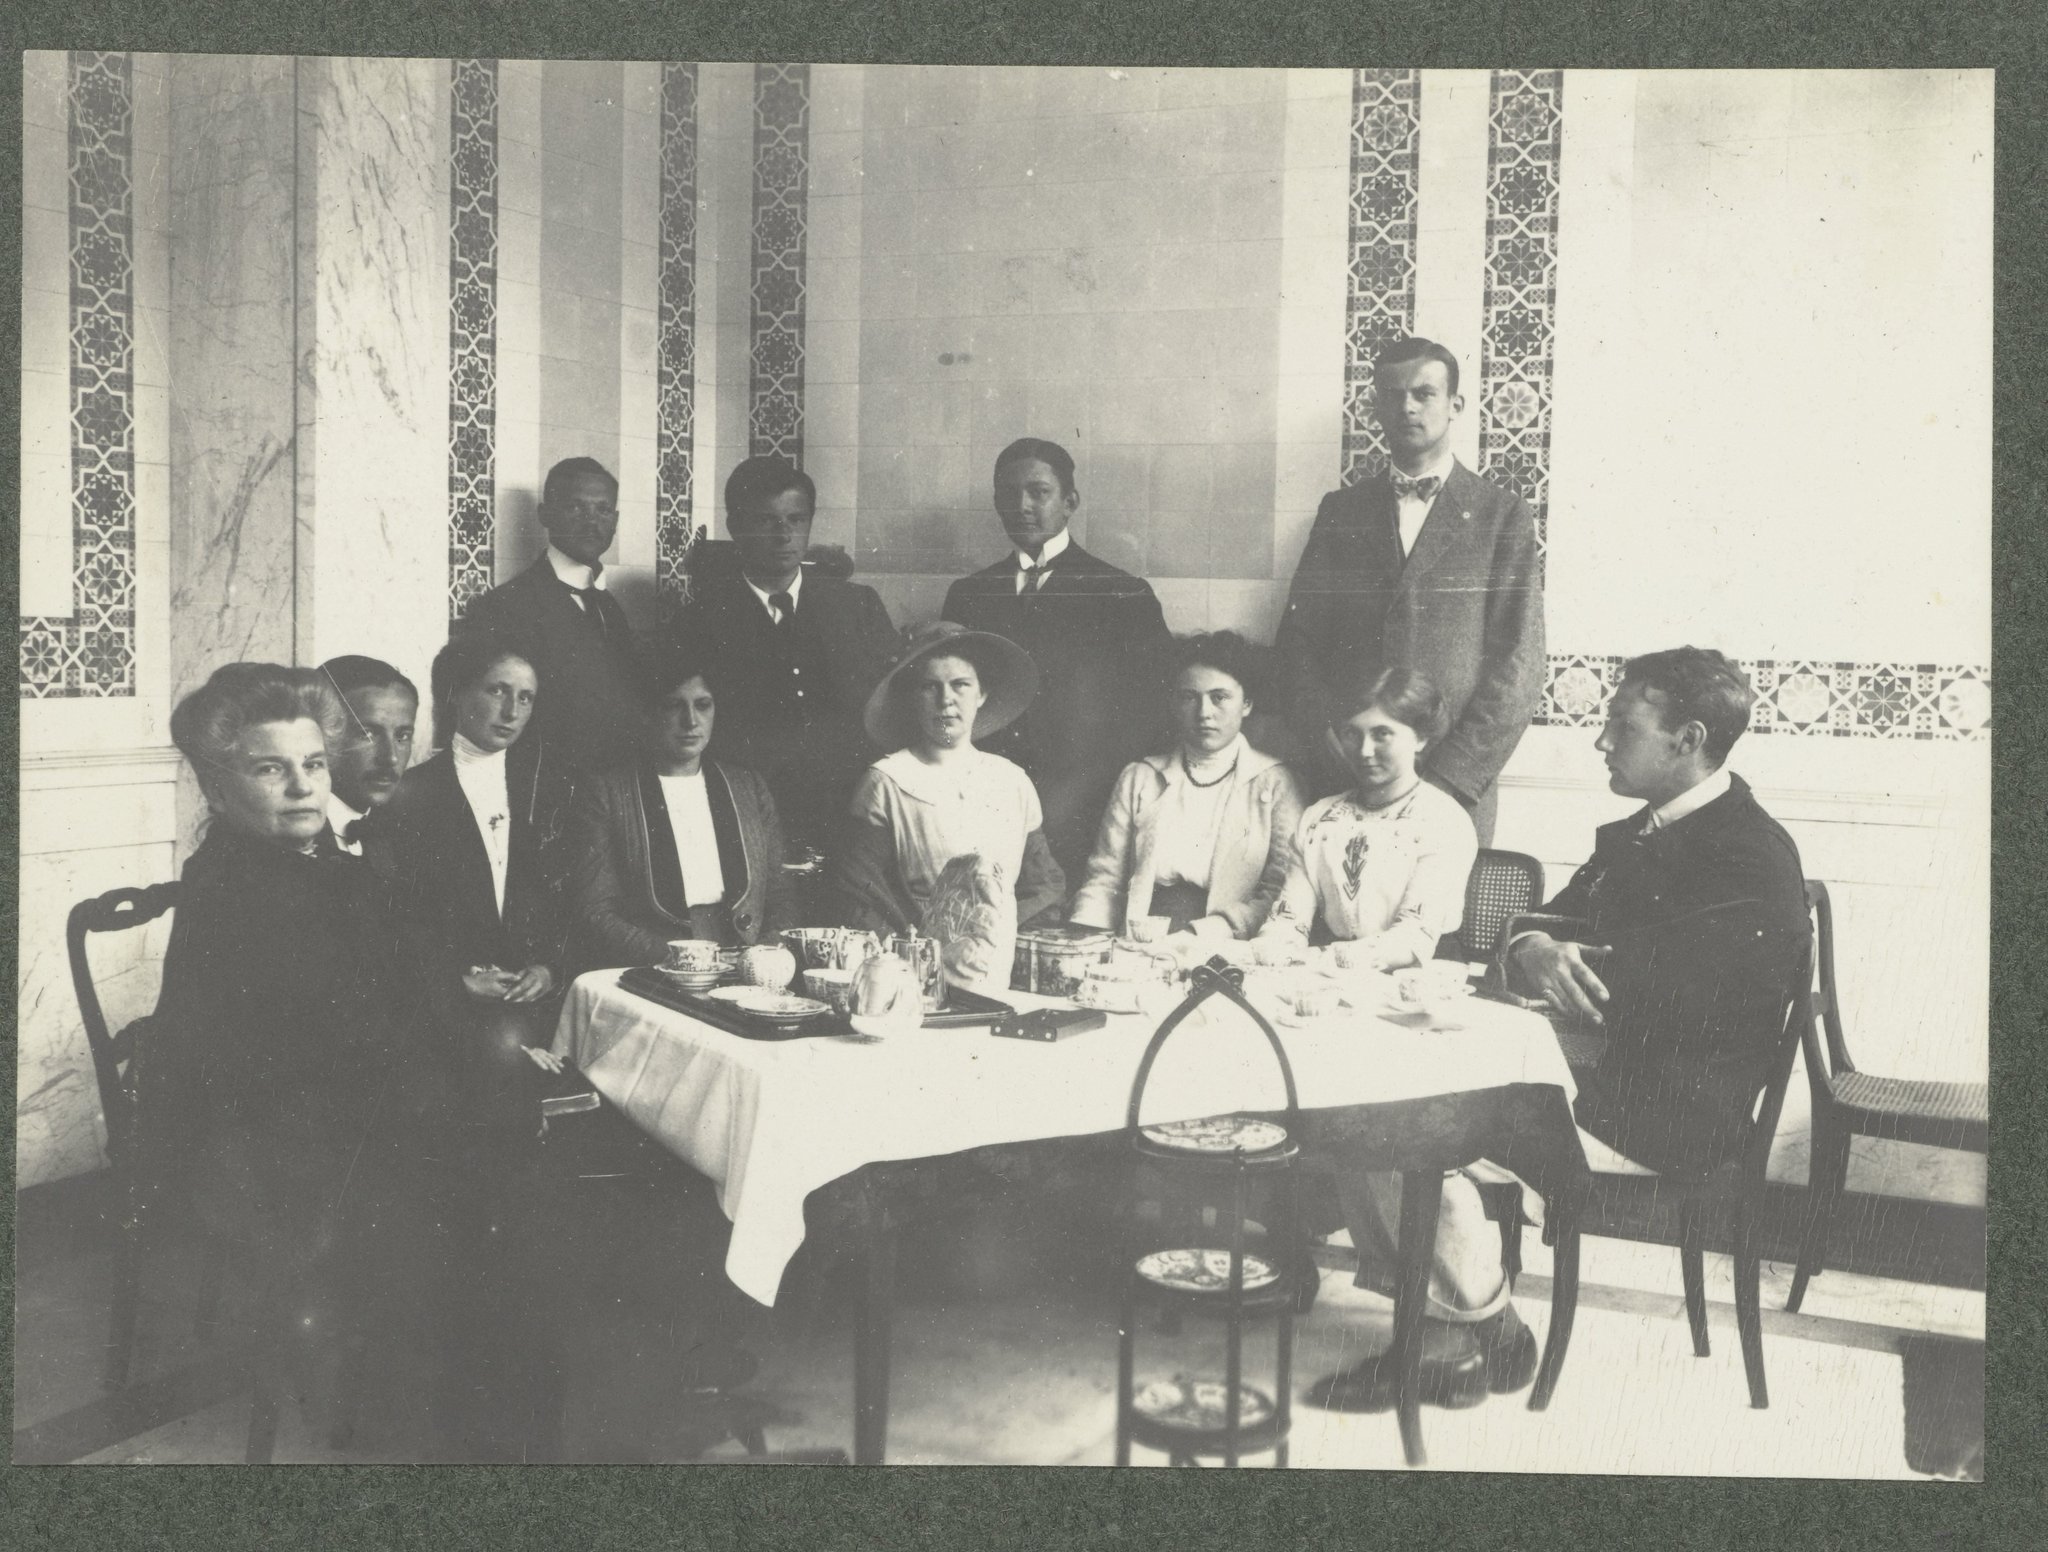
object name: photograph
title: Familie Kessler aan de koffietafel in het buitenhuis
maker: geldolph adriaan kessler (dolph)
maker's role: fotograaf, industrieel, voetballer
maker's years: 1884-1945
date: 1913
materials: paper, photographic support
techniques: photography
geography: netherlands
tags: goes, digna fransen van de putte, huize de paauw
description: Links vooraan zit mevrouw Kessler de Lange